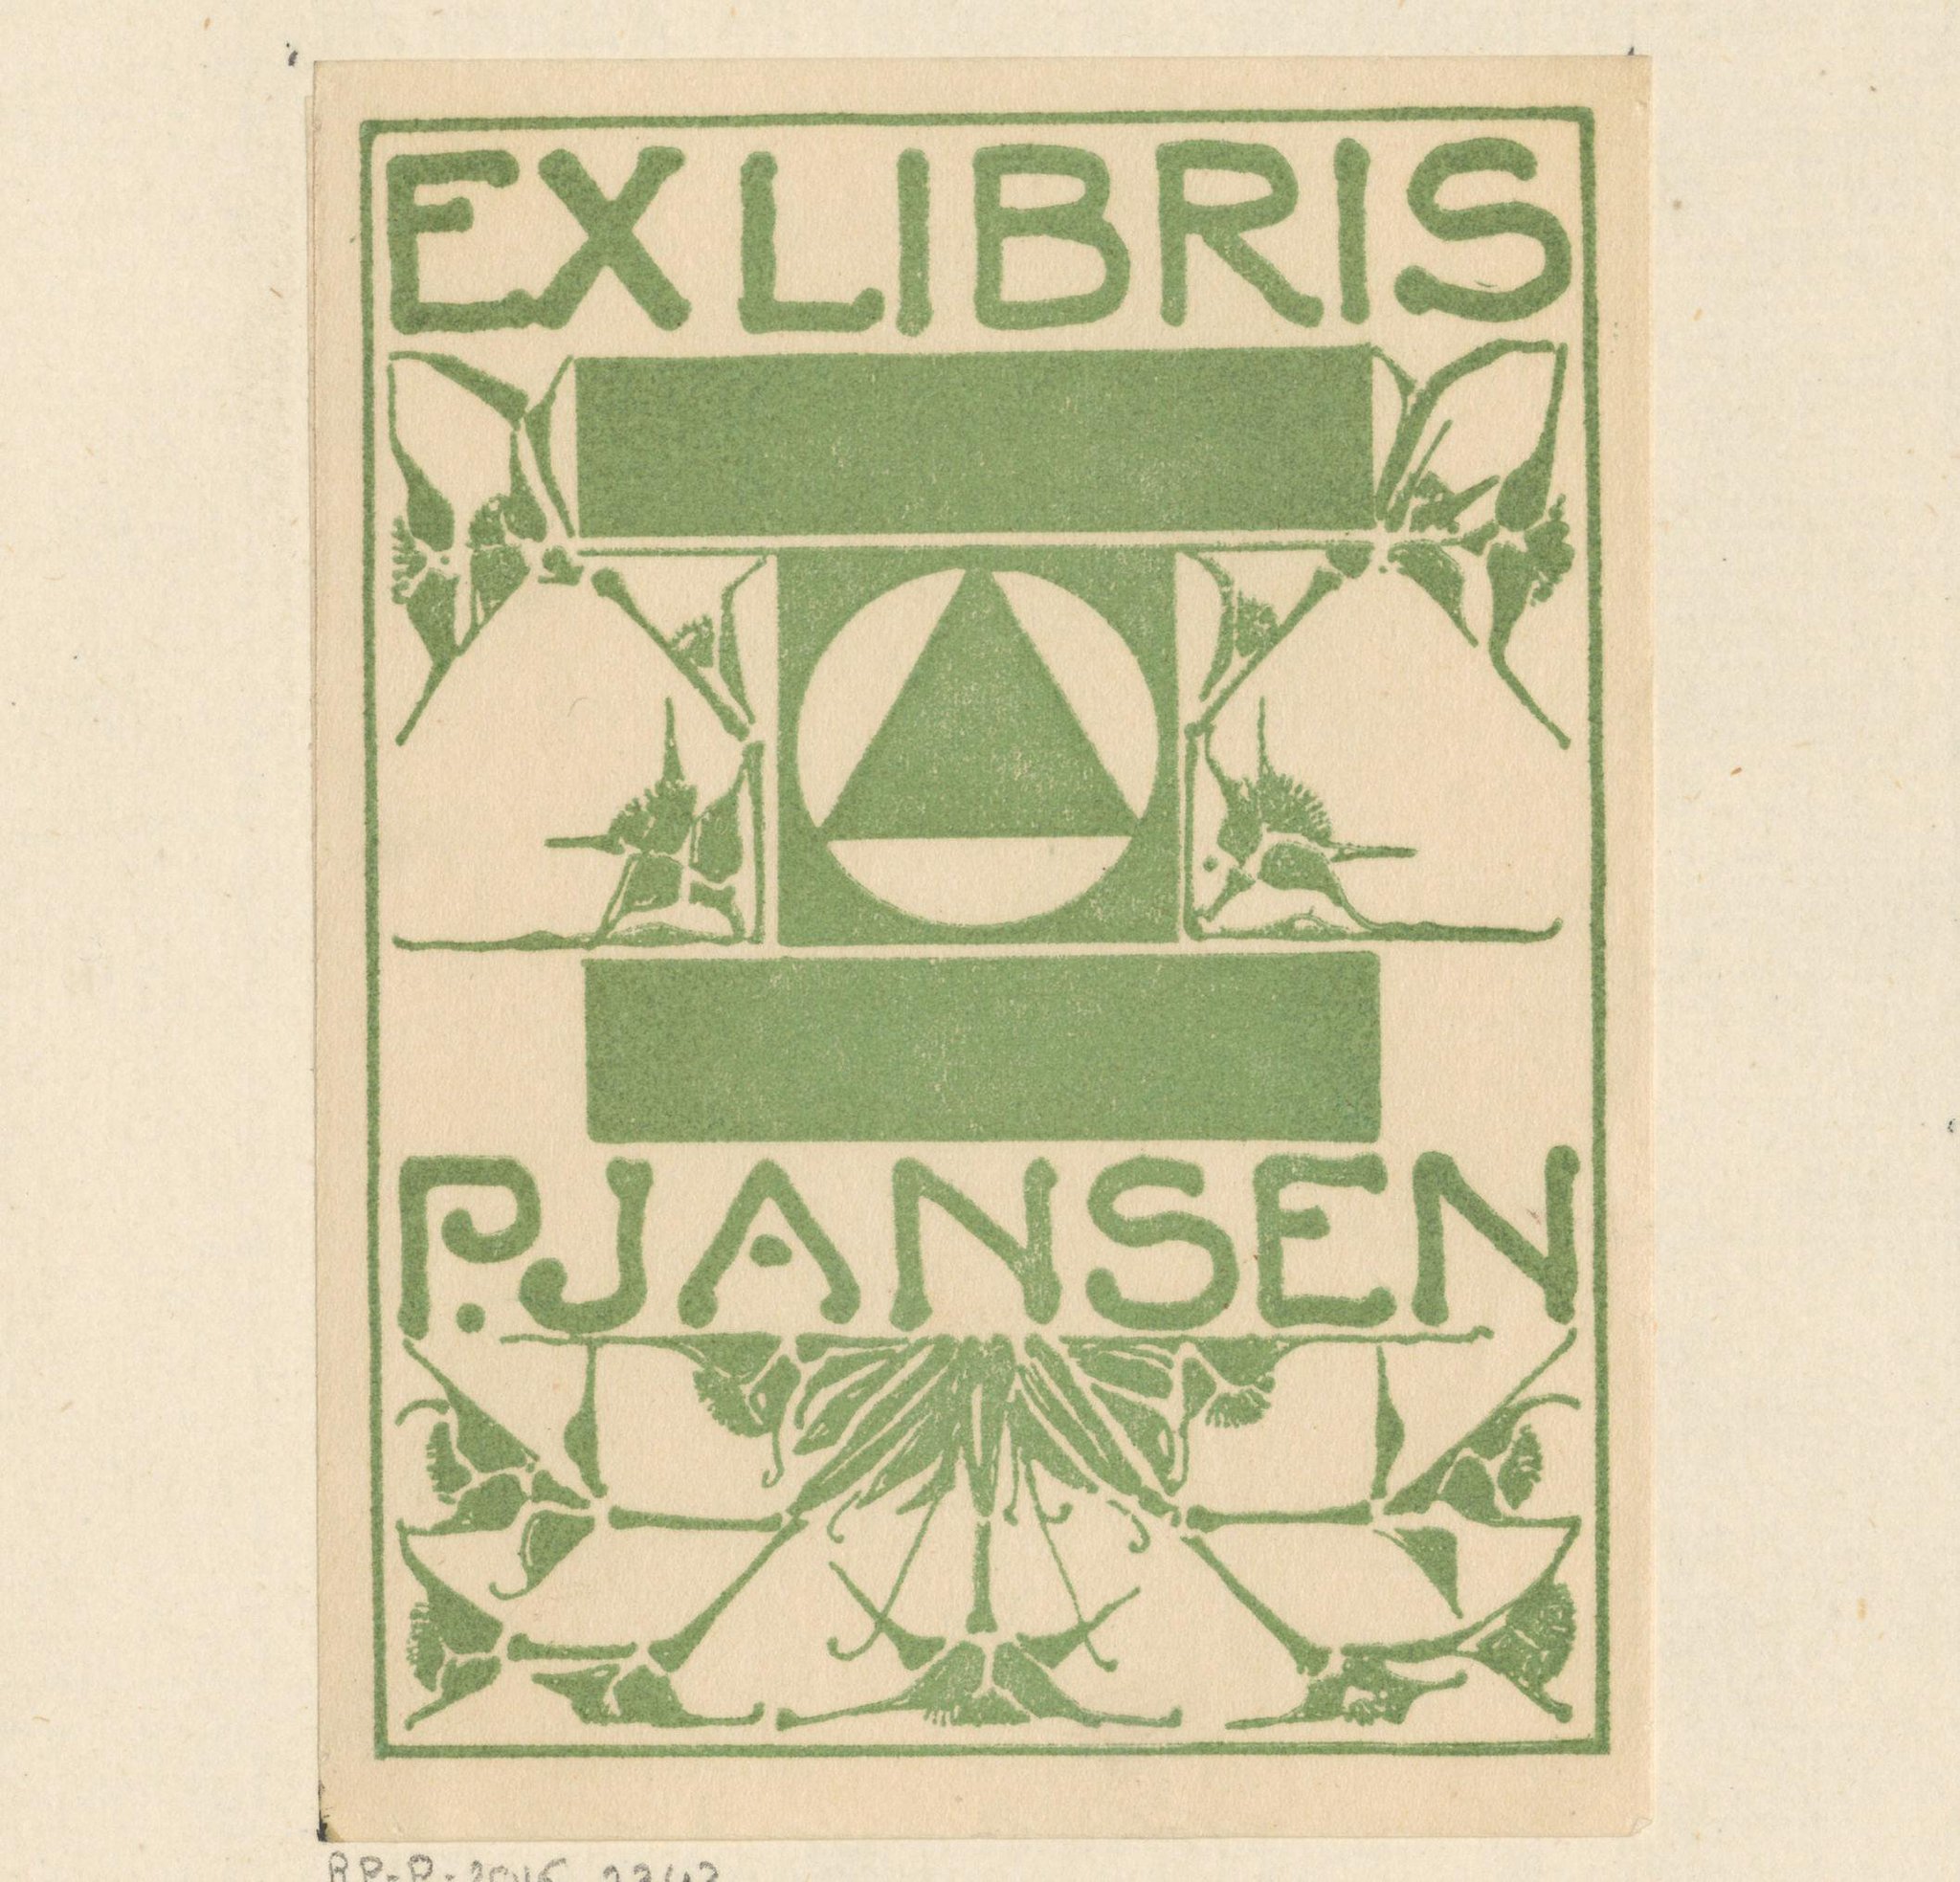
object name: bookplate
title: Ex libris van P. Jansen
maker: bernard willem wierink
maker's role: draughtsman, print maker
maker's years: 1856-1939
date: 1866-1939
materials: paper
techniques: printing block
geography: netherlands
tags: flowers ~ ornament - aa - stylized, triangle (~ planimetry, geometry), circle (~ planimetry, geometry)